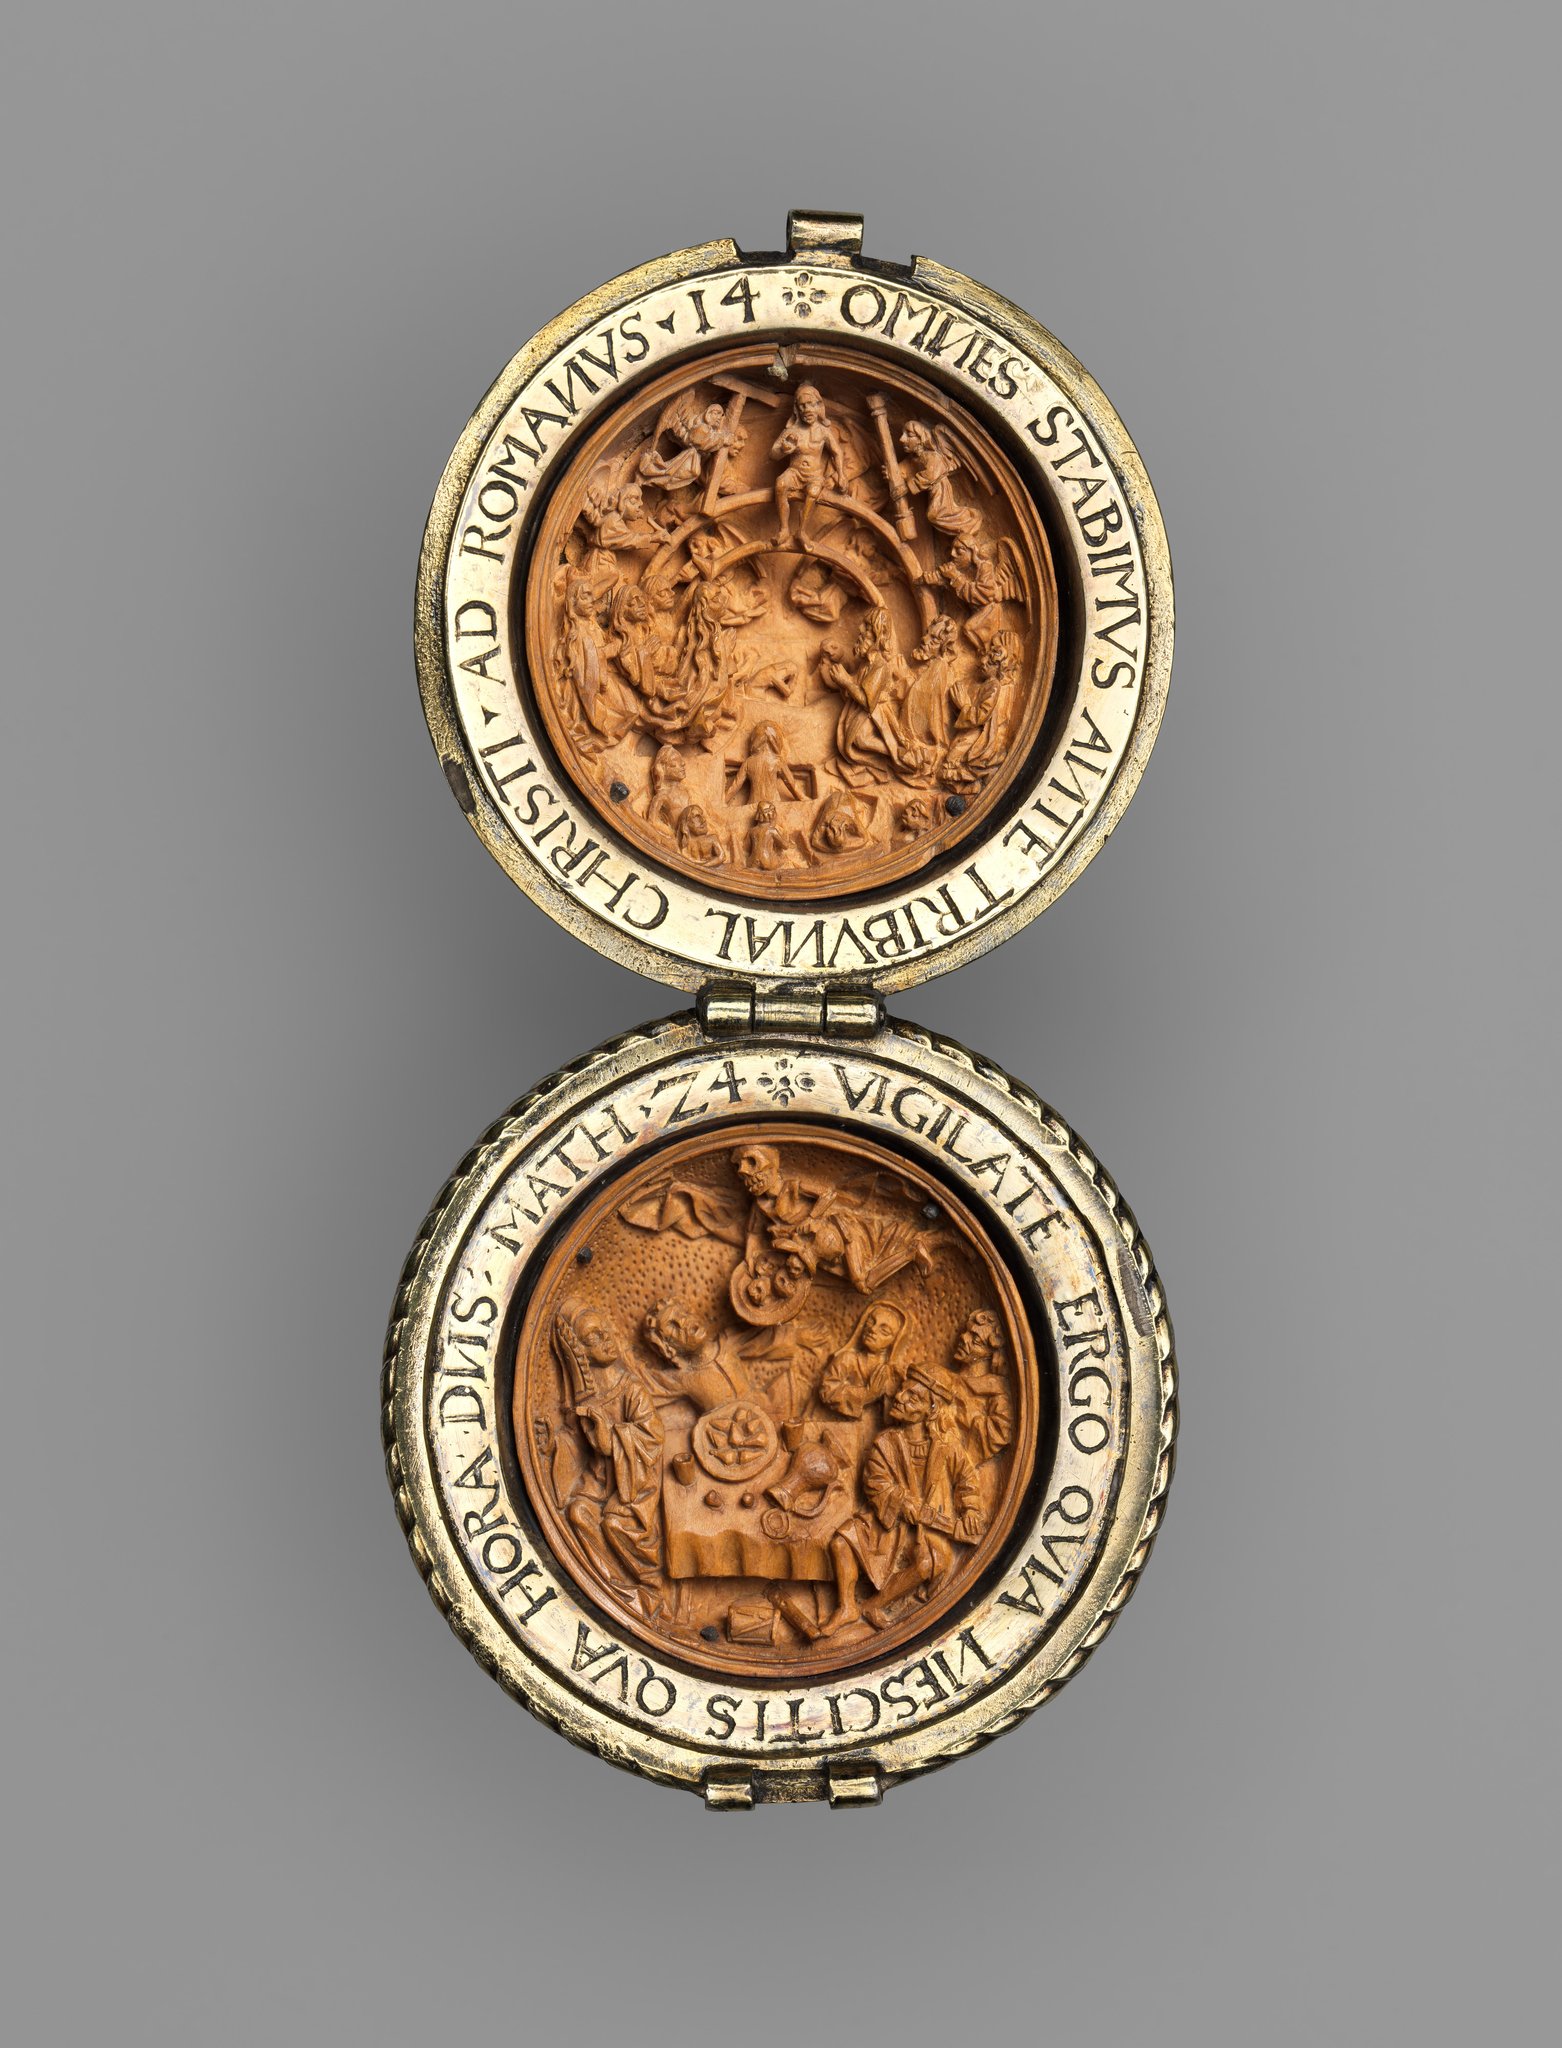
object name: rosary bead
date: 1525-1550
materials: wood, gilt silver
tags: skeletons,men,women,angels,last judgement,dining